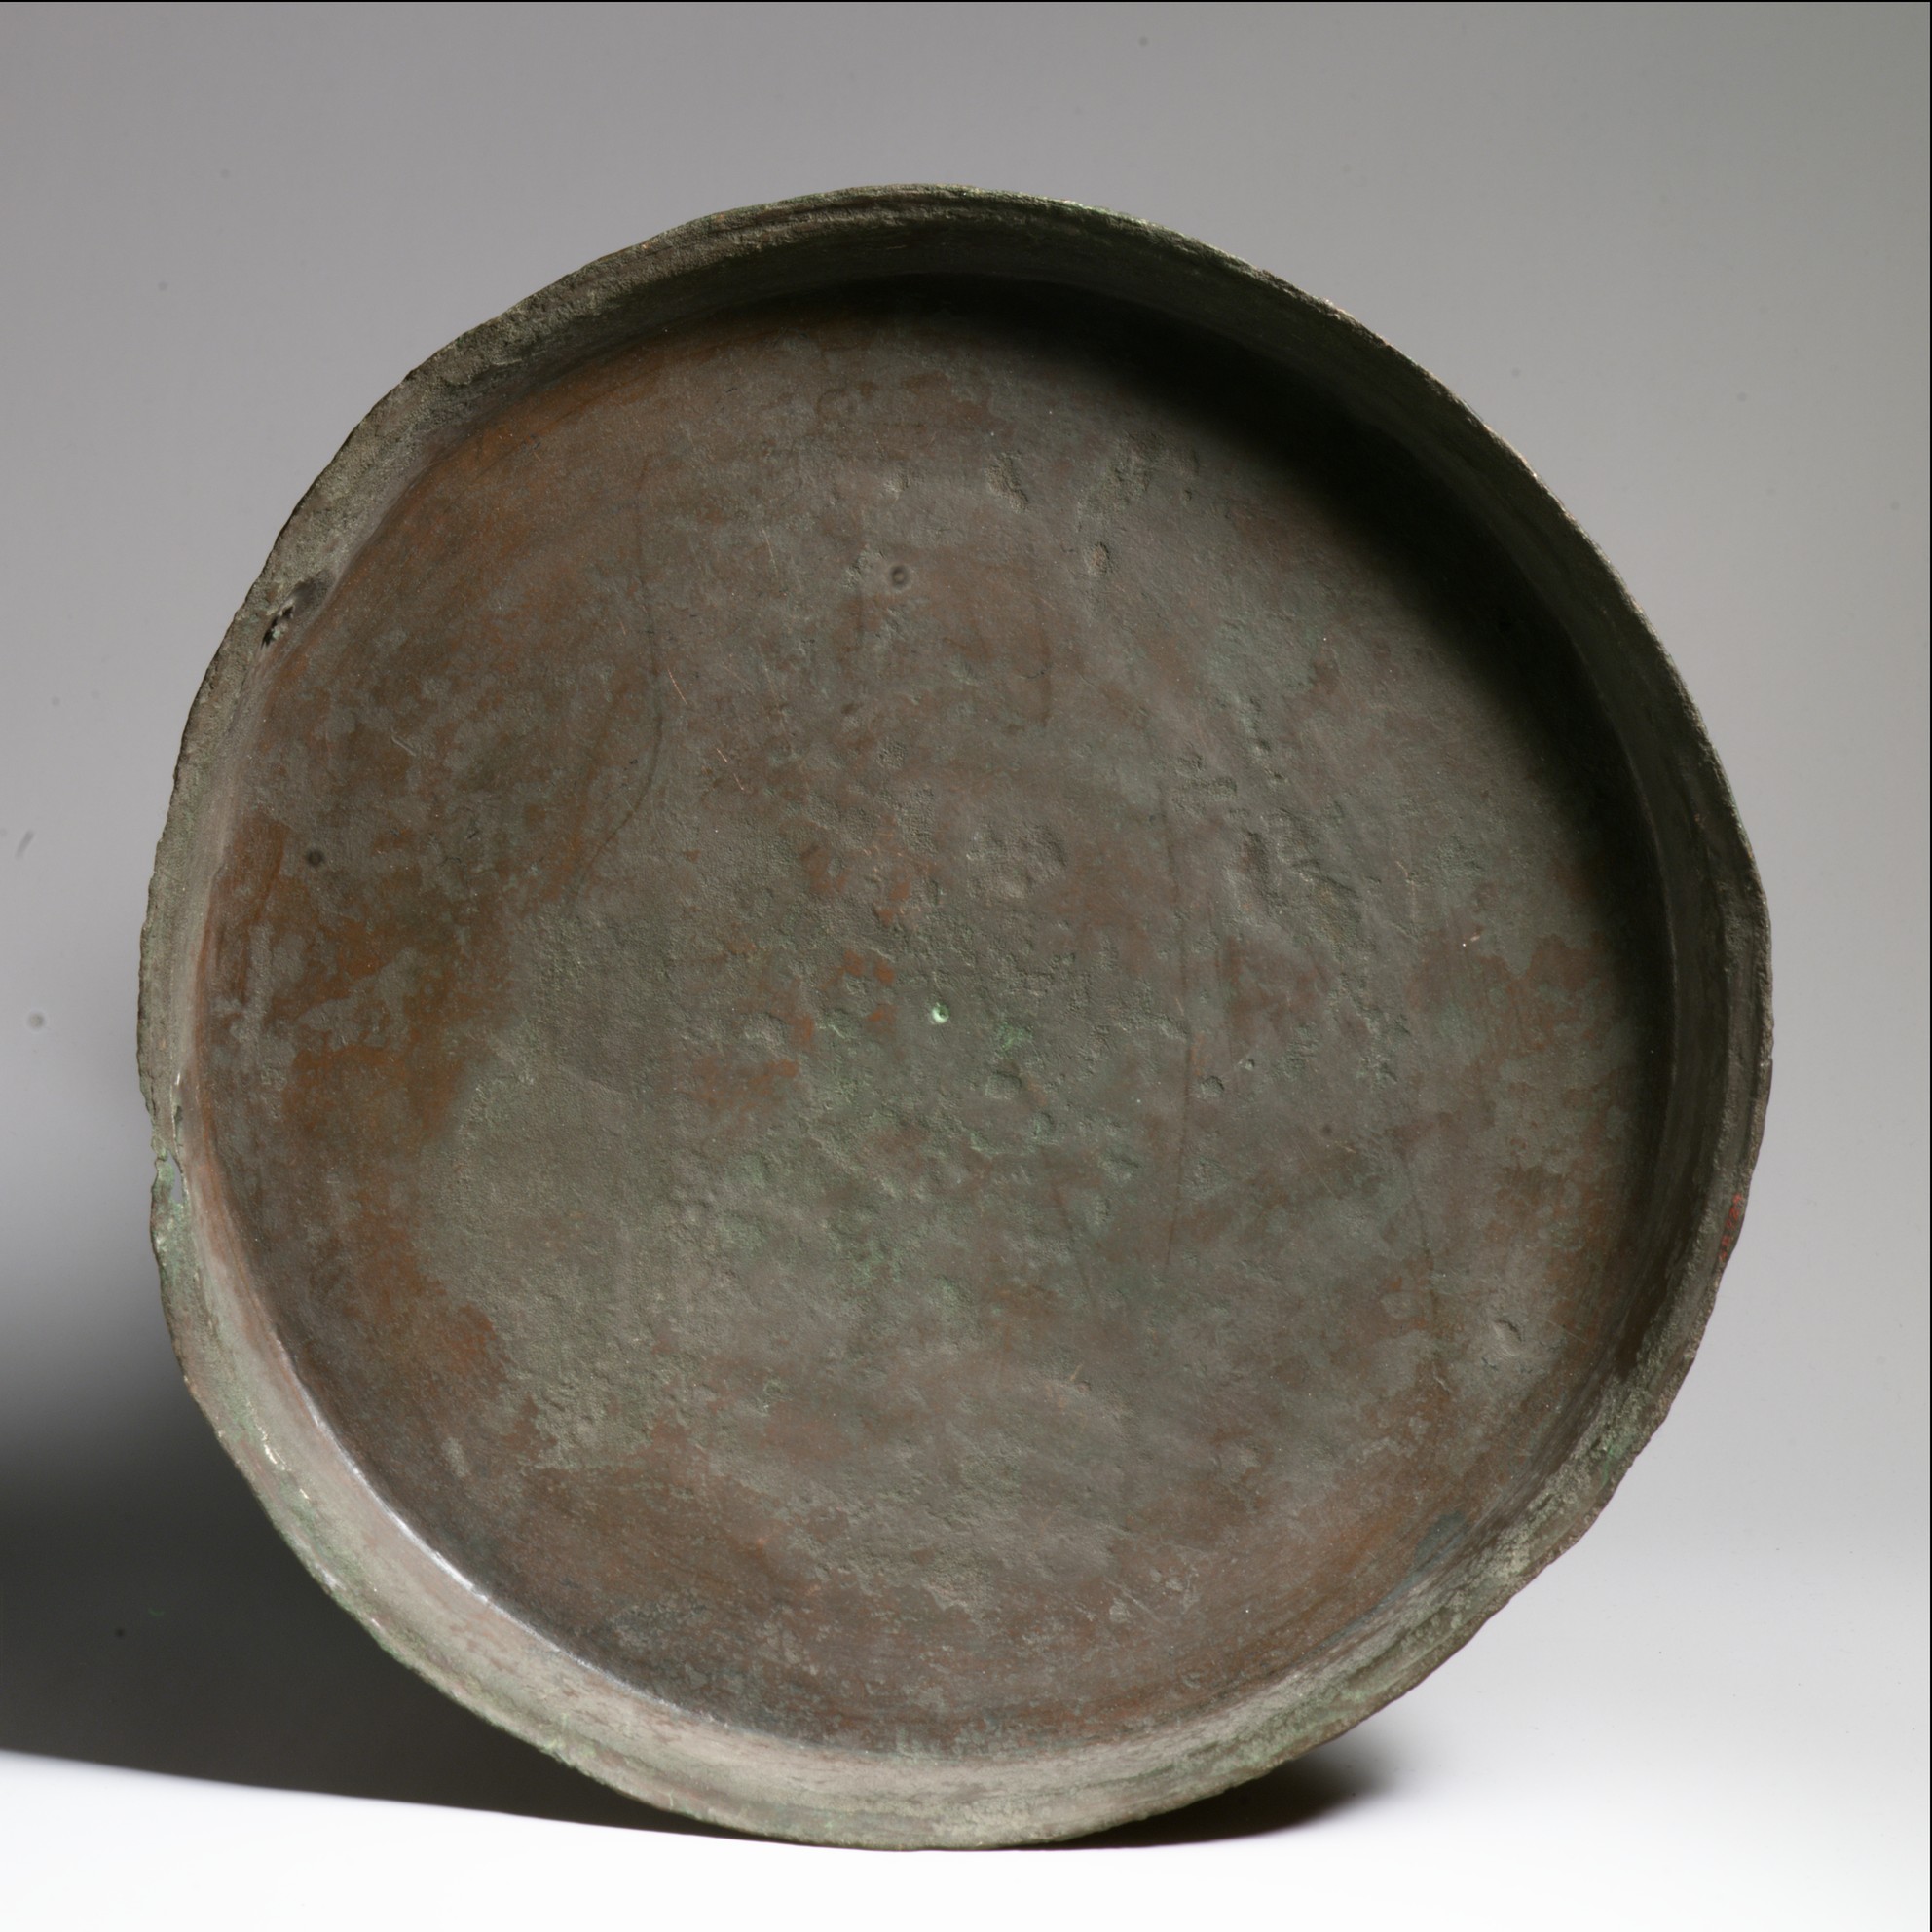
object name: patera, trulla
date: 7000 BCE-330 CE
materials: bronze